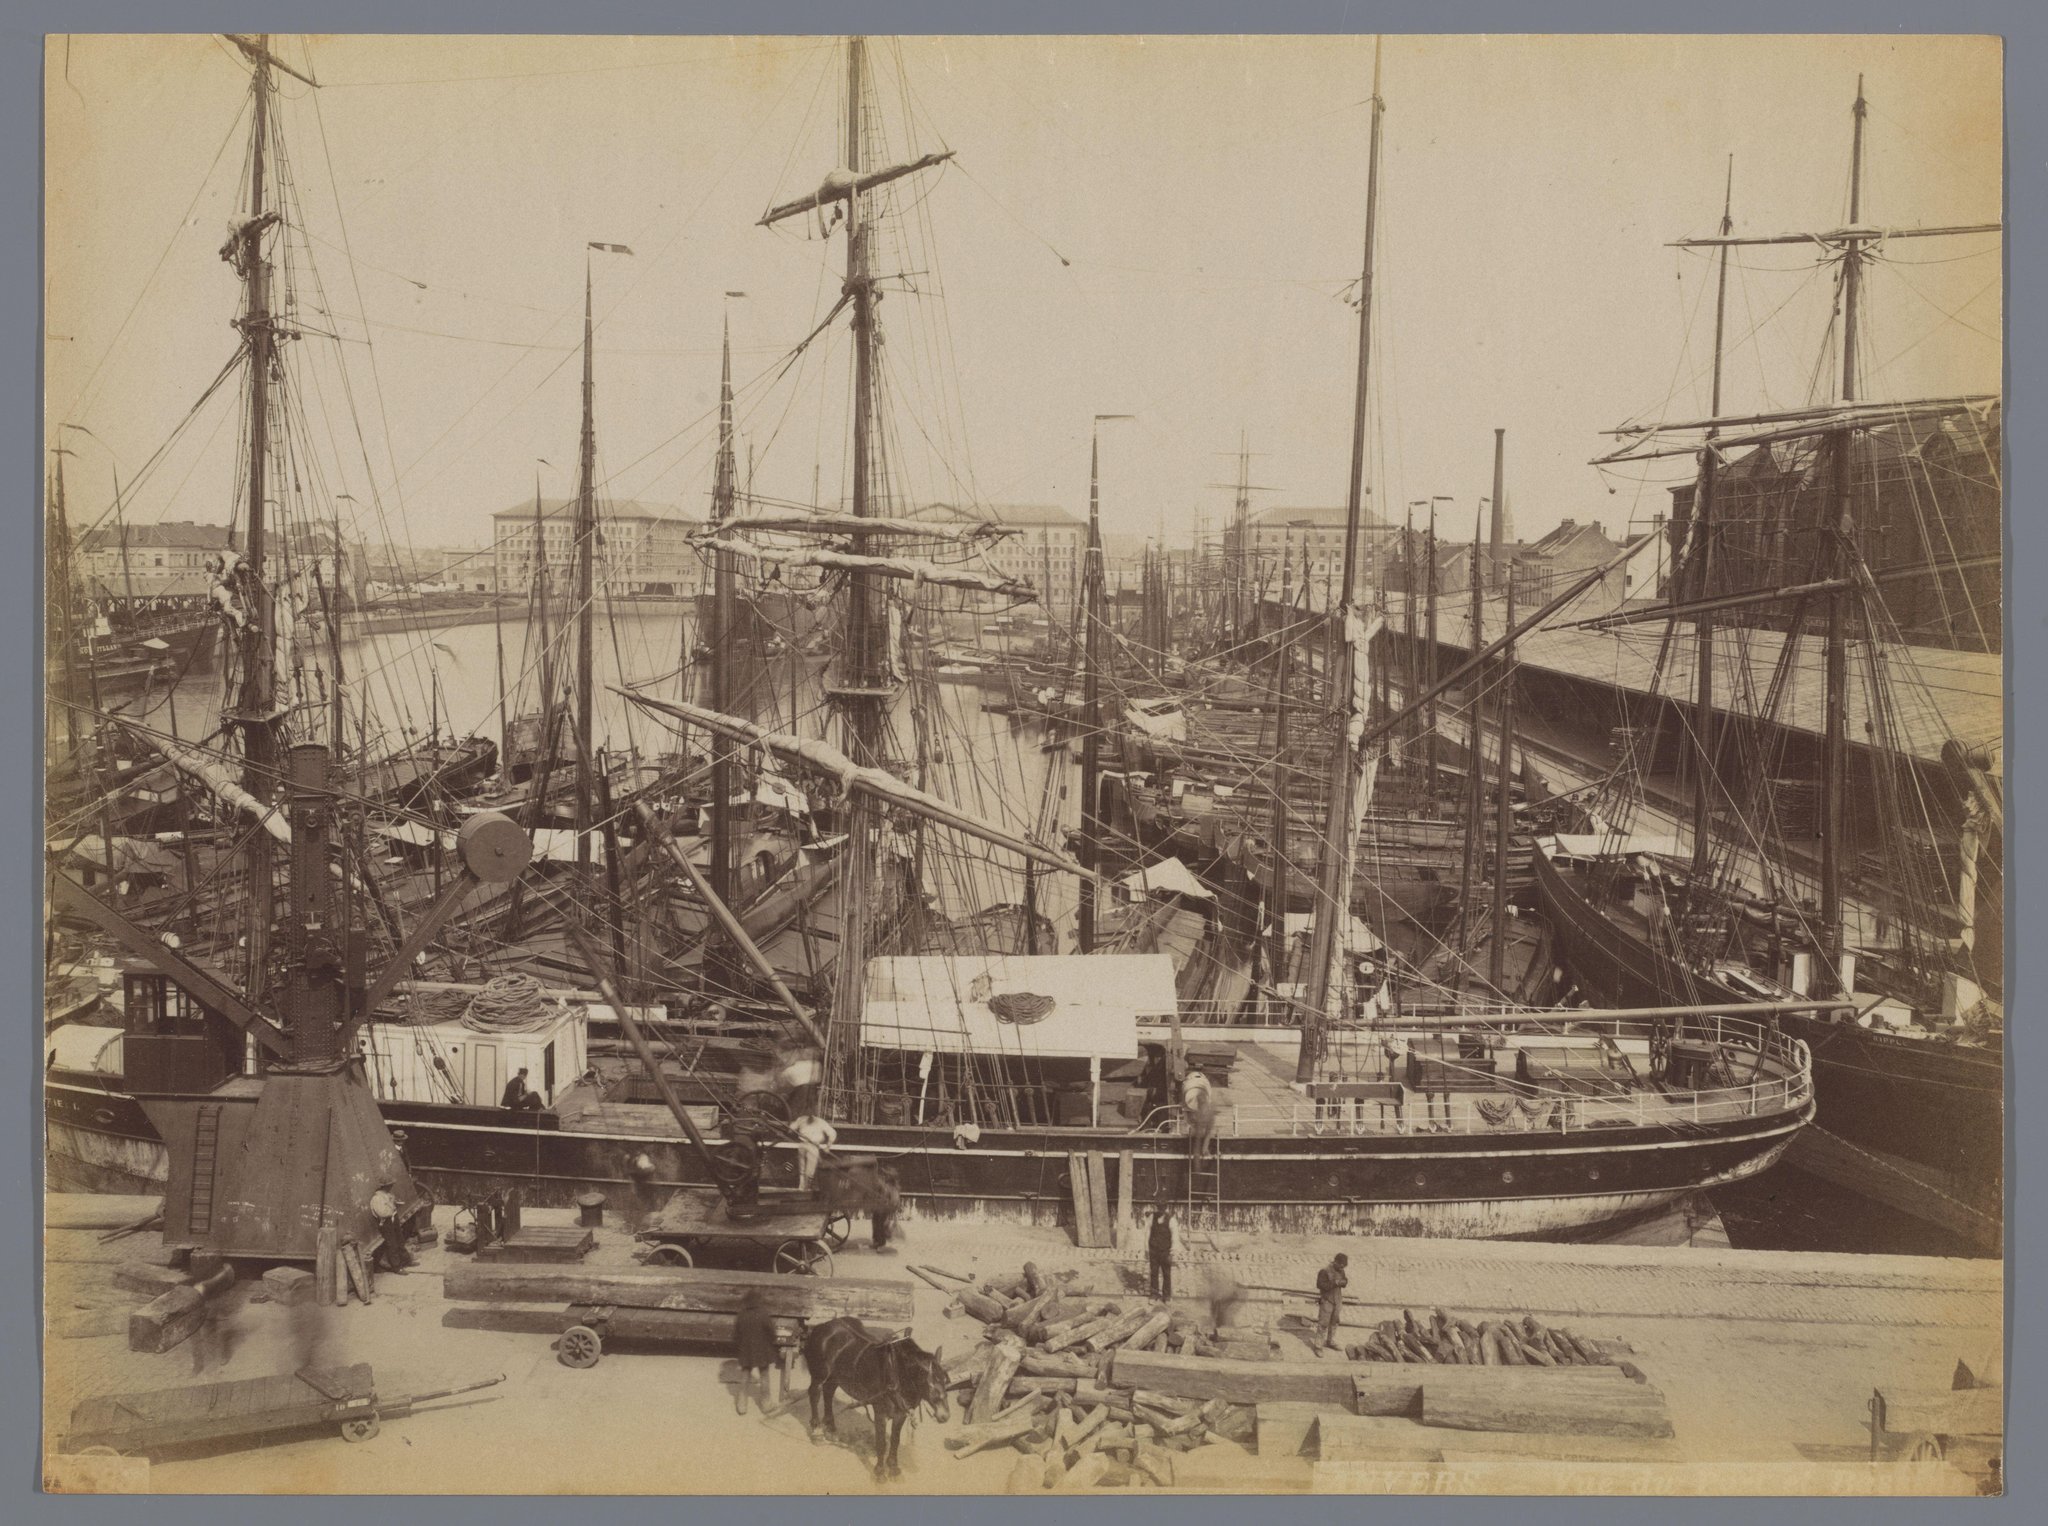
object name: photograph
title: Gezicht op de oude haven van Antwerpen, België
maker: Anonymous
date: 1870-1906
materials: paper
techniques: albumen print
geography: antwerp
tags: harbour, pier, quay, wharf, antwerp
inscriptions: retailer's mark: ‘PHOTOGRAPHIES/ GRAVURES ANCIENNES ET MODERNES/ OBJETS D'ART/ G. ZAZZARINI & CO./ Successeur de F. TESSARO/ 37, Marché aux Souliers, 37/ ANVERS’